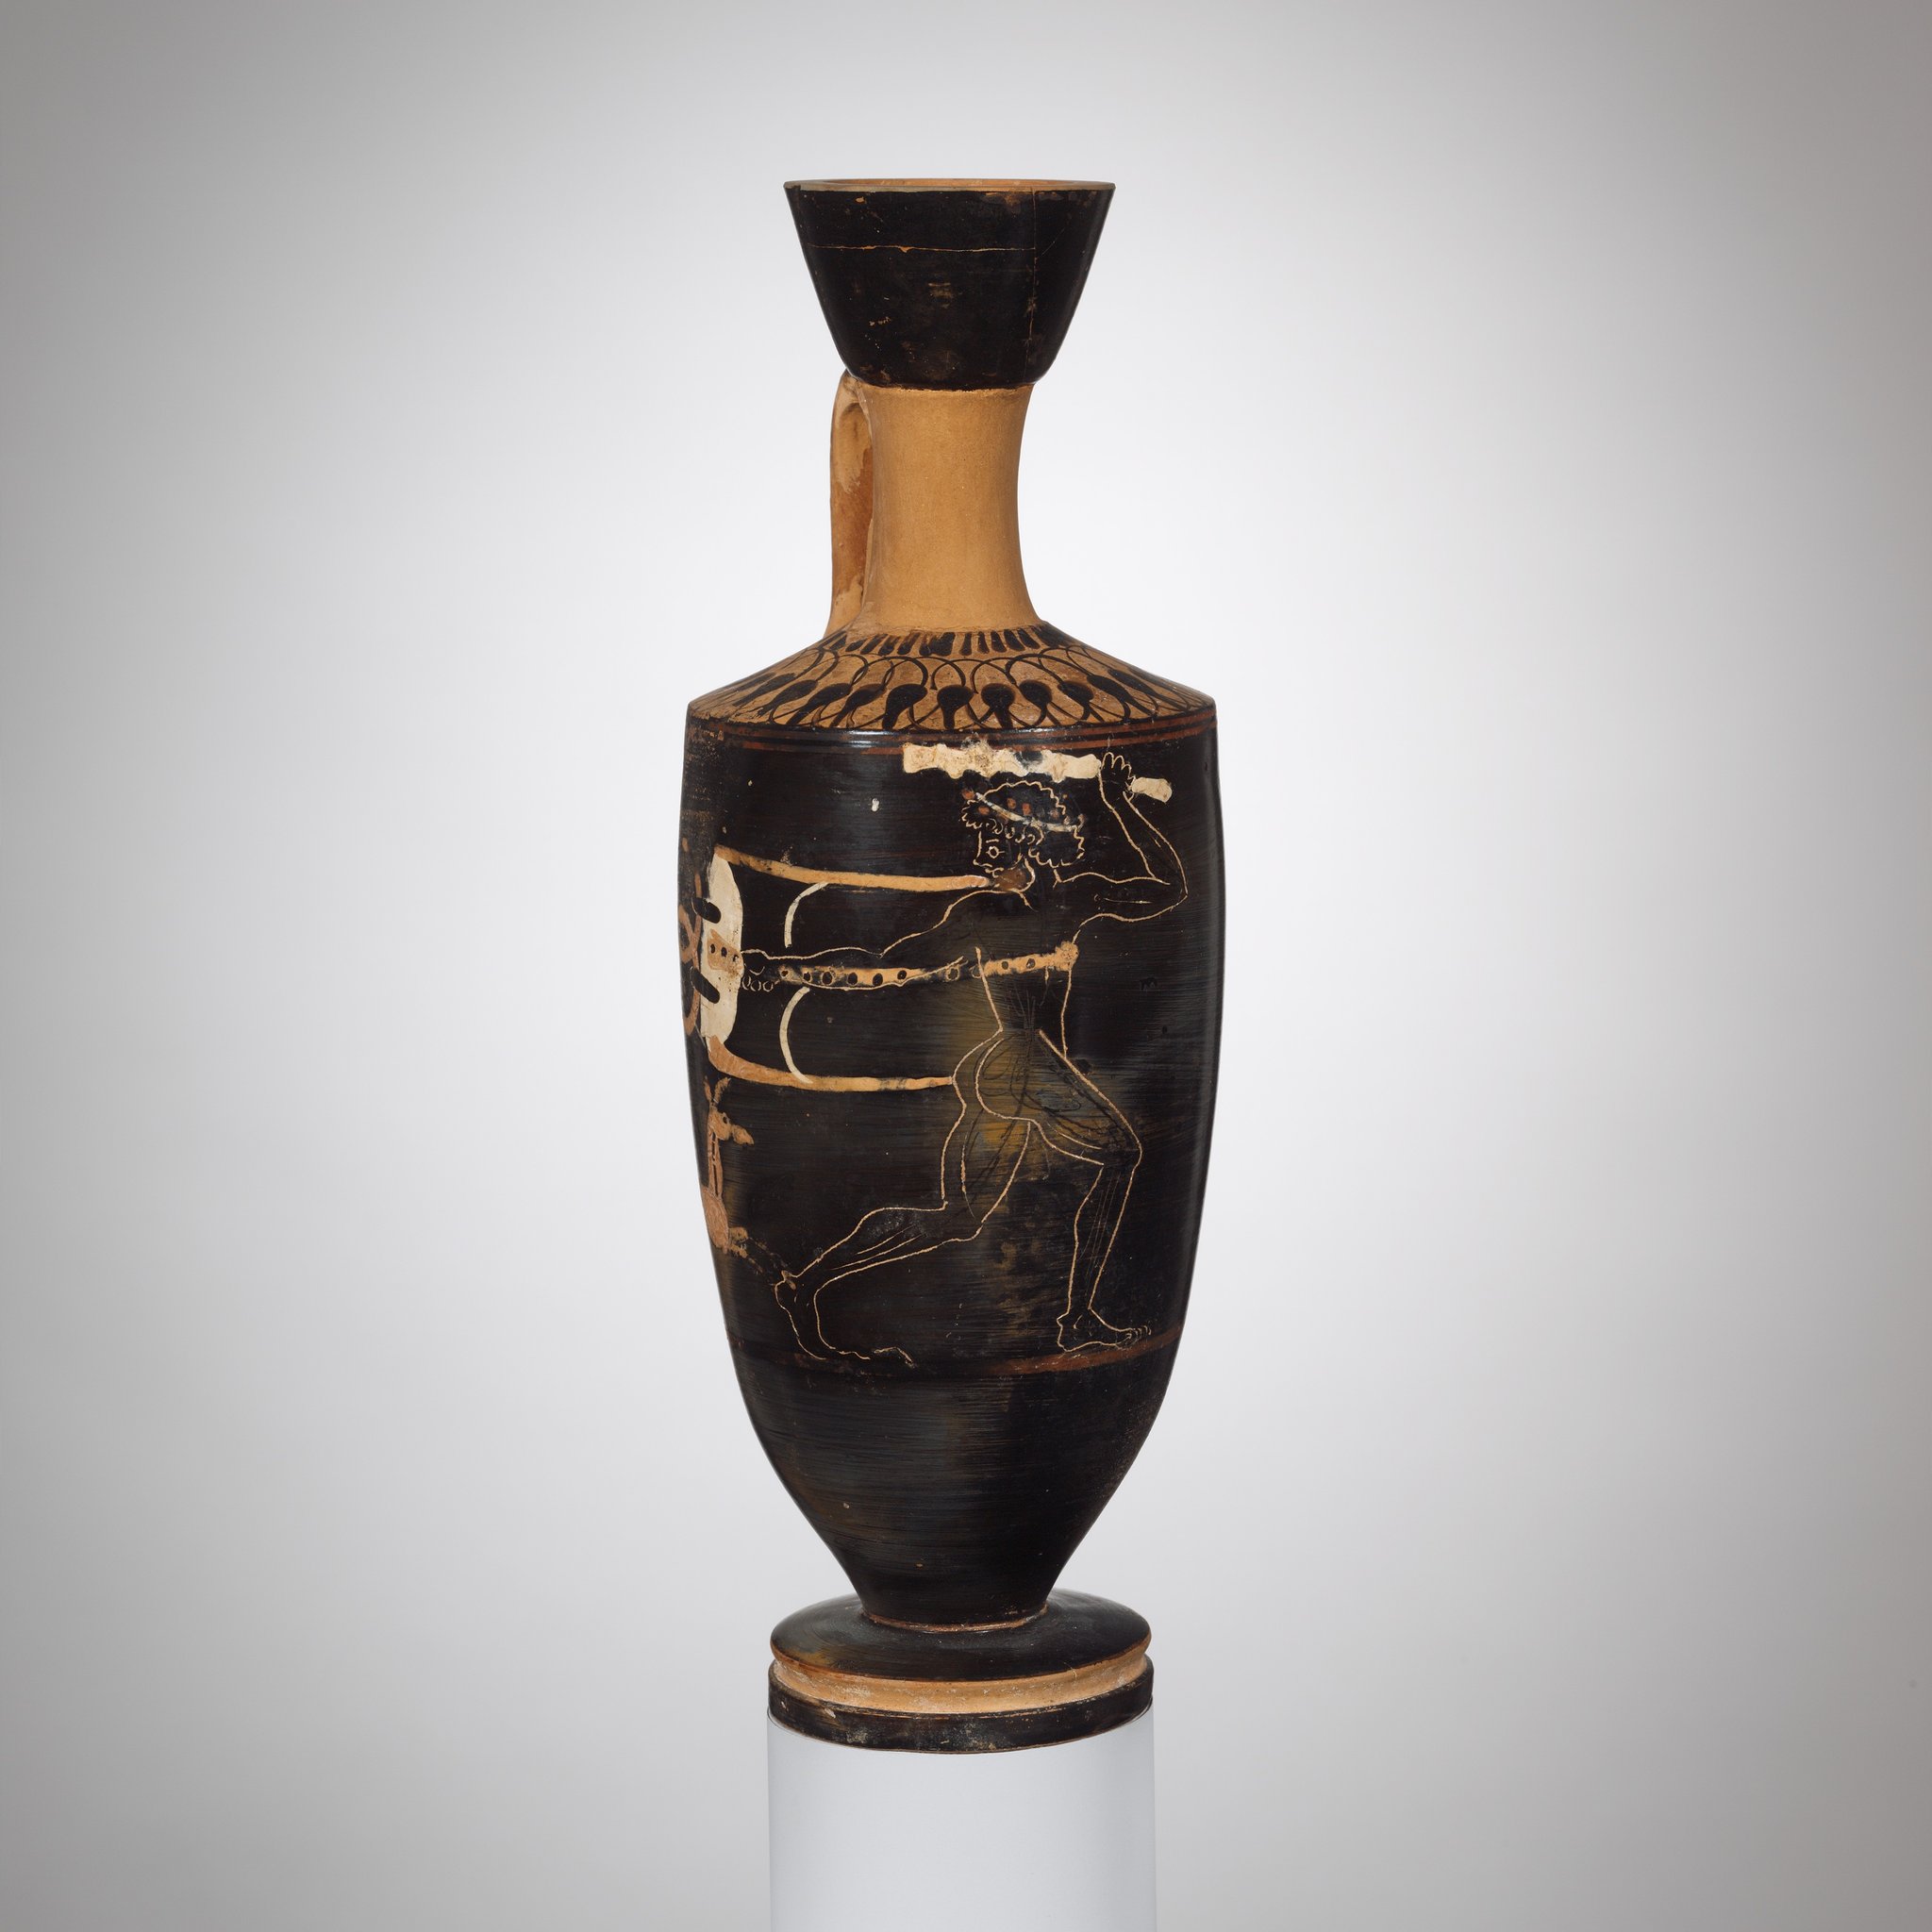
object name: lekythos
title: Terracotta lekythos (oil flask)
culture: greek, attic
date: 500 BCE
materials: terracotta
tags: animals,herakles